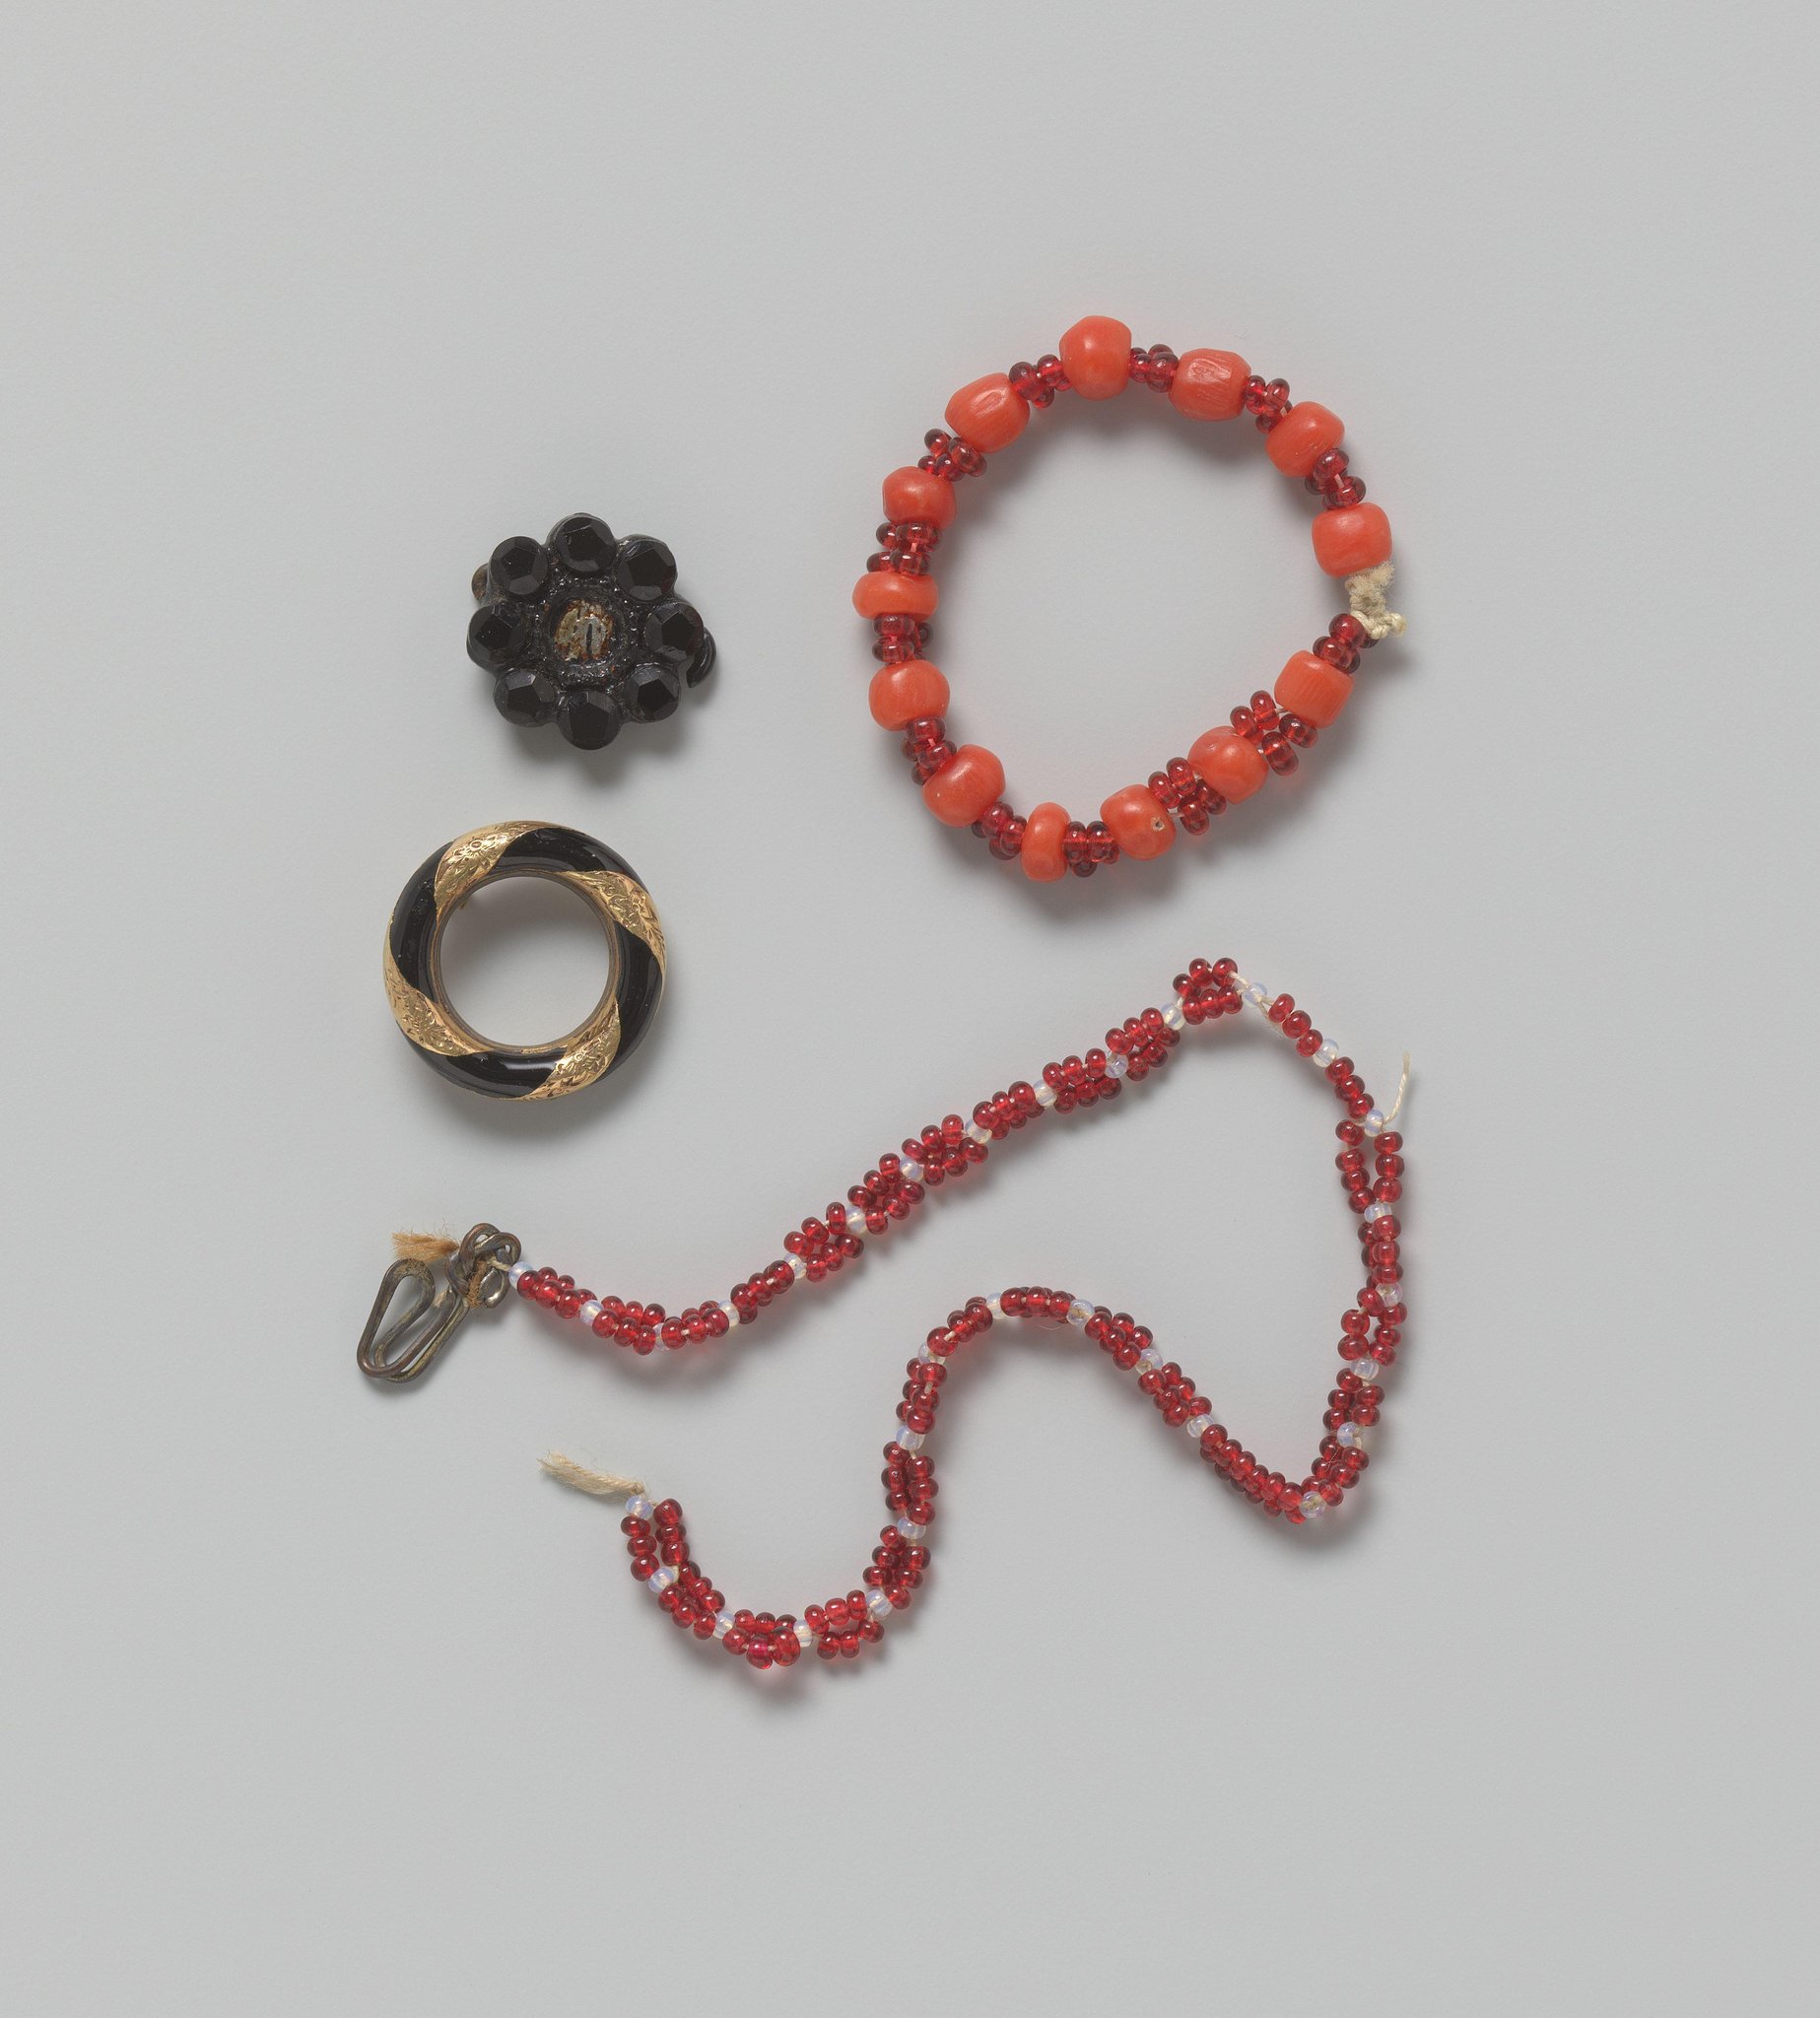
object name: jewellery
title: Bloem, zwart, met metalen hart en twee ophangoogjes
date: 1880-1890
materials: metal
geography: netherlands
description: Bloem, zwart, met metalen hart en twee ophangoogjes.